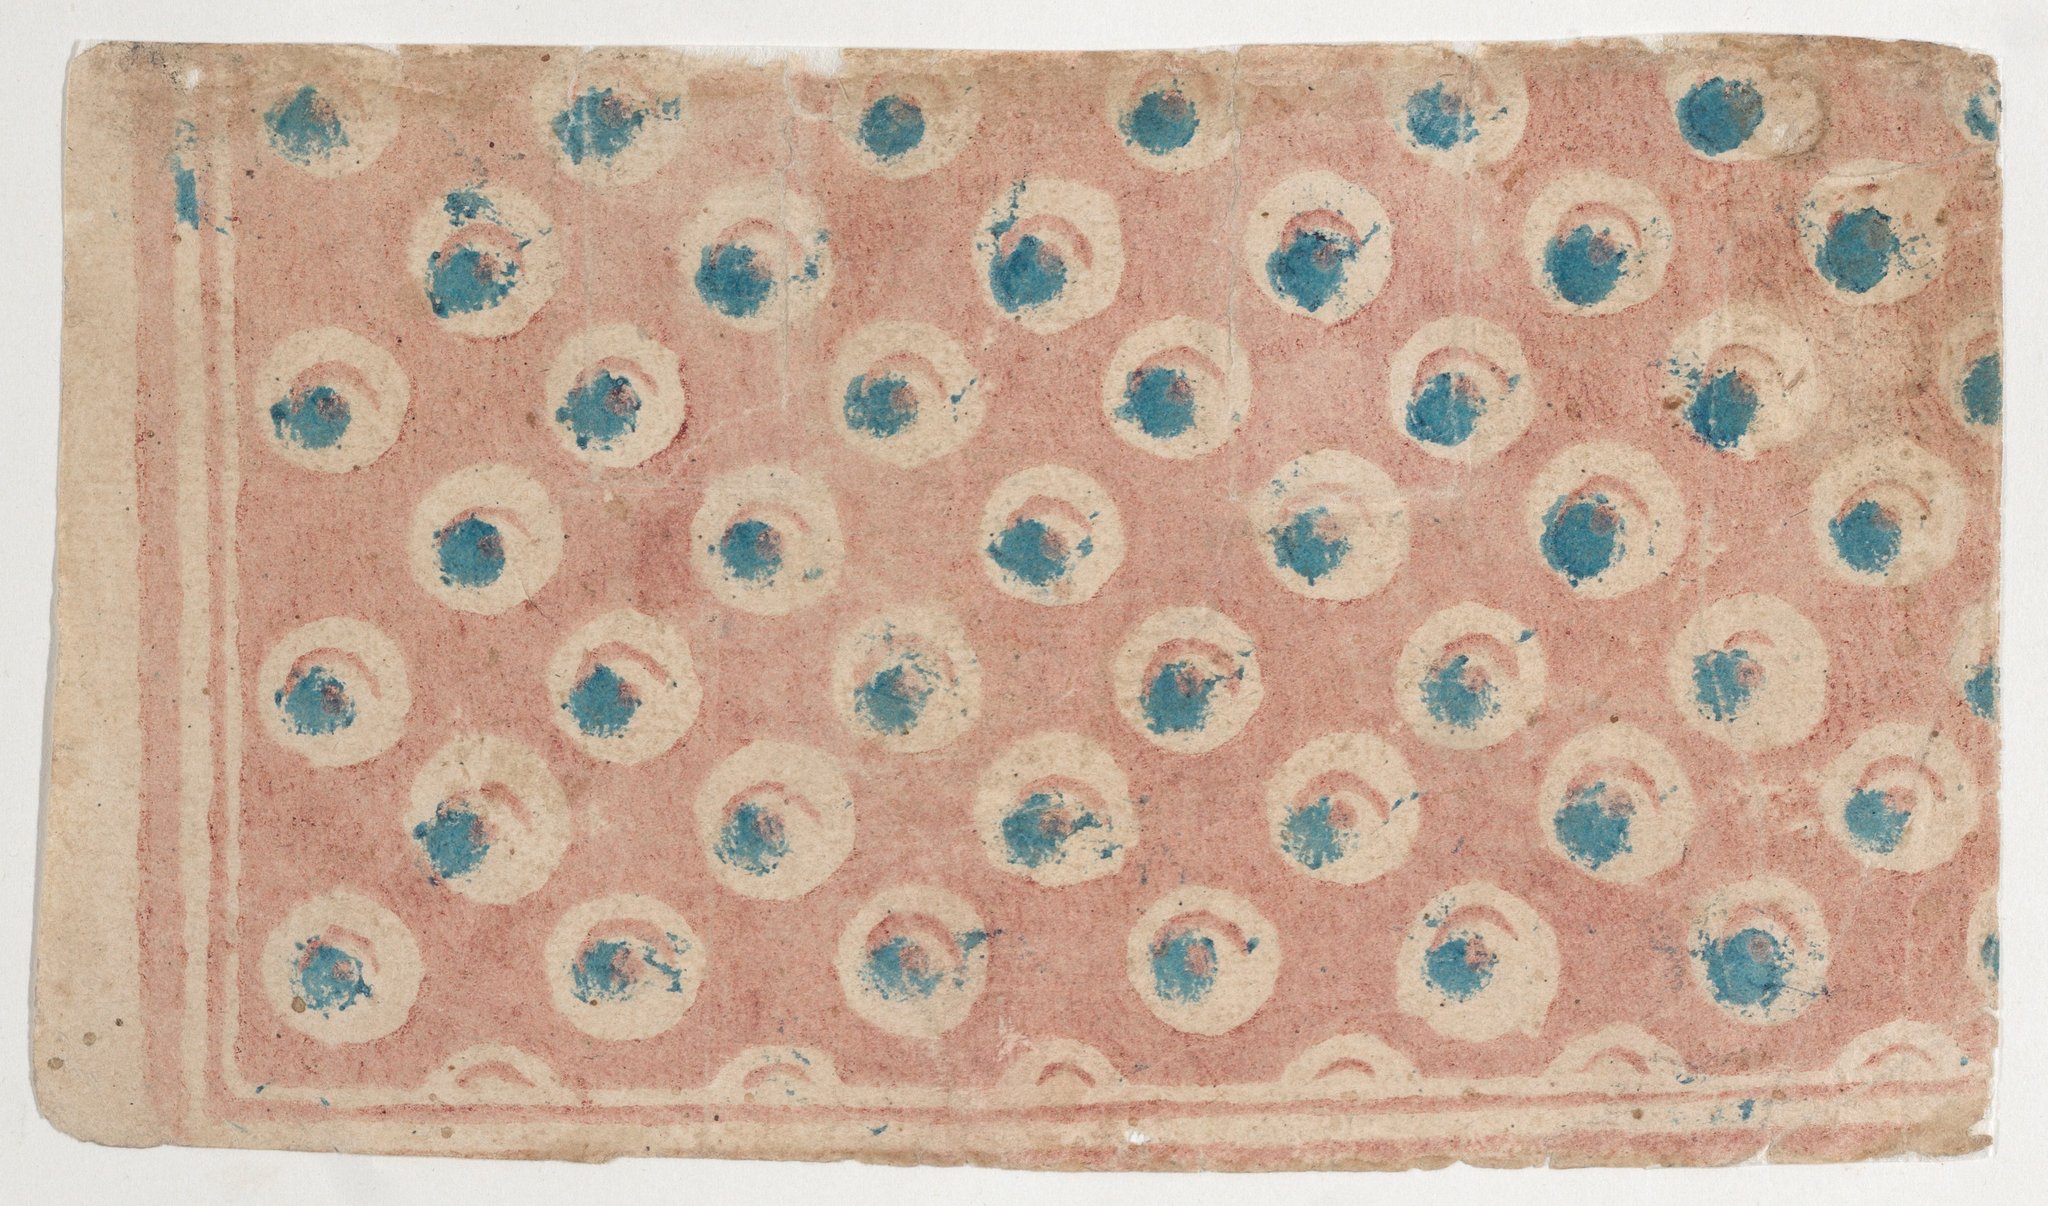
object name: print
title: Pink sheet with blue dot pattern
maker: Anonymous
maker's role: artist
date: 1701-1800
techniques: relief print